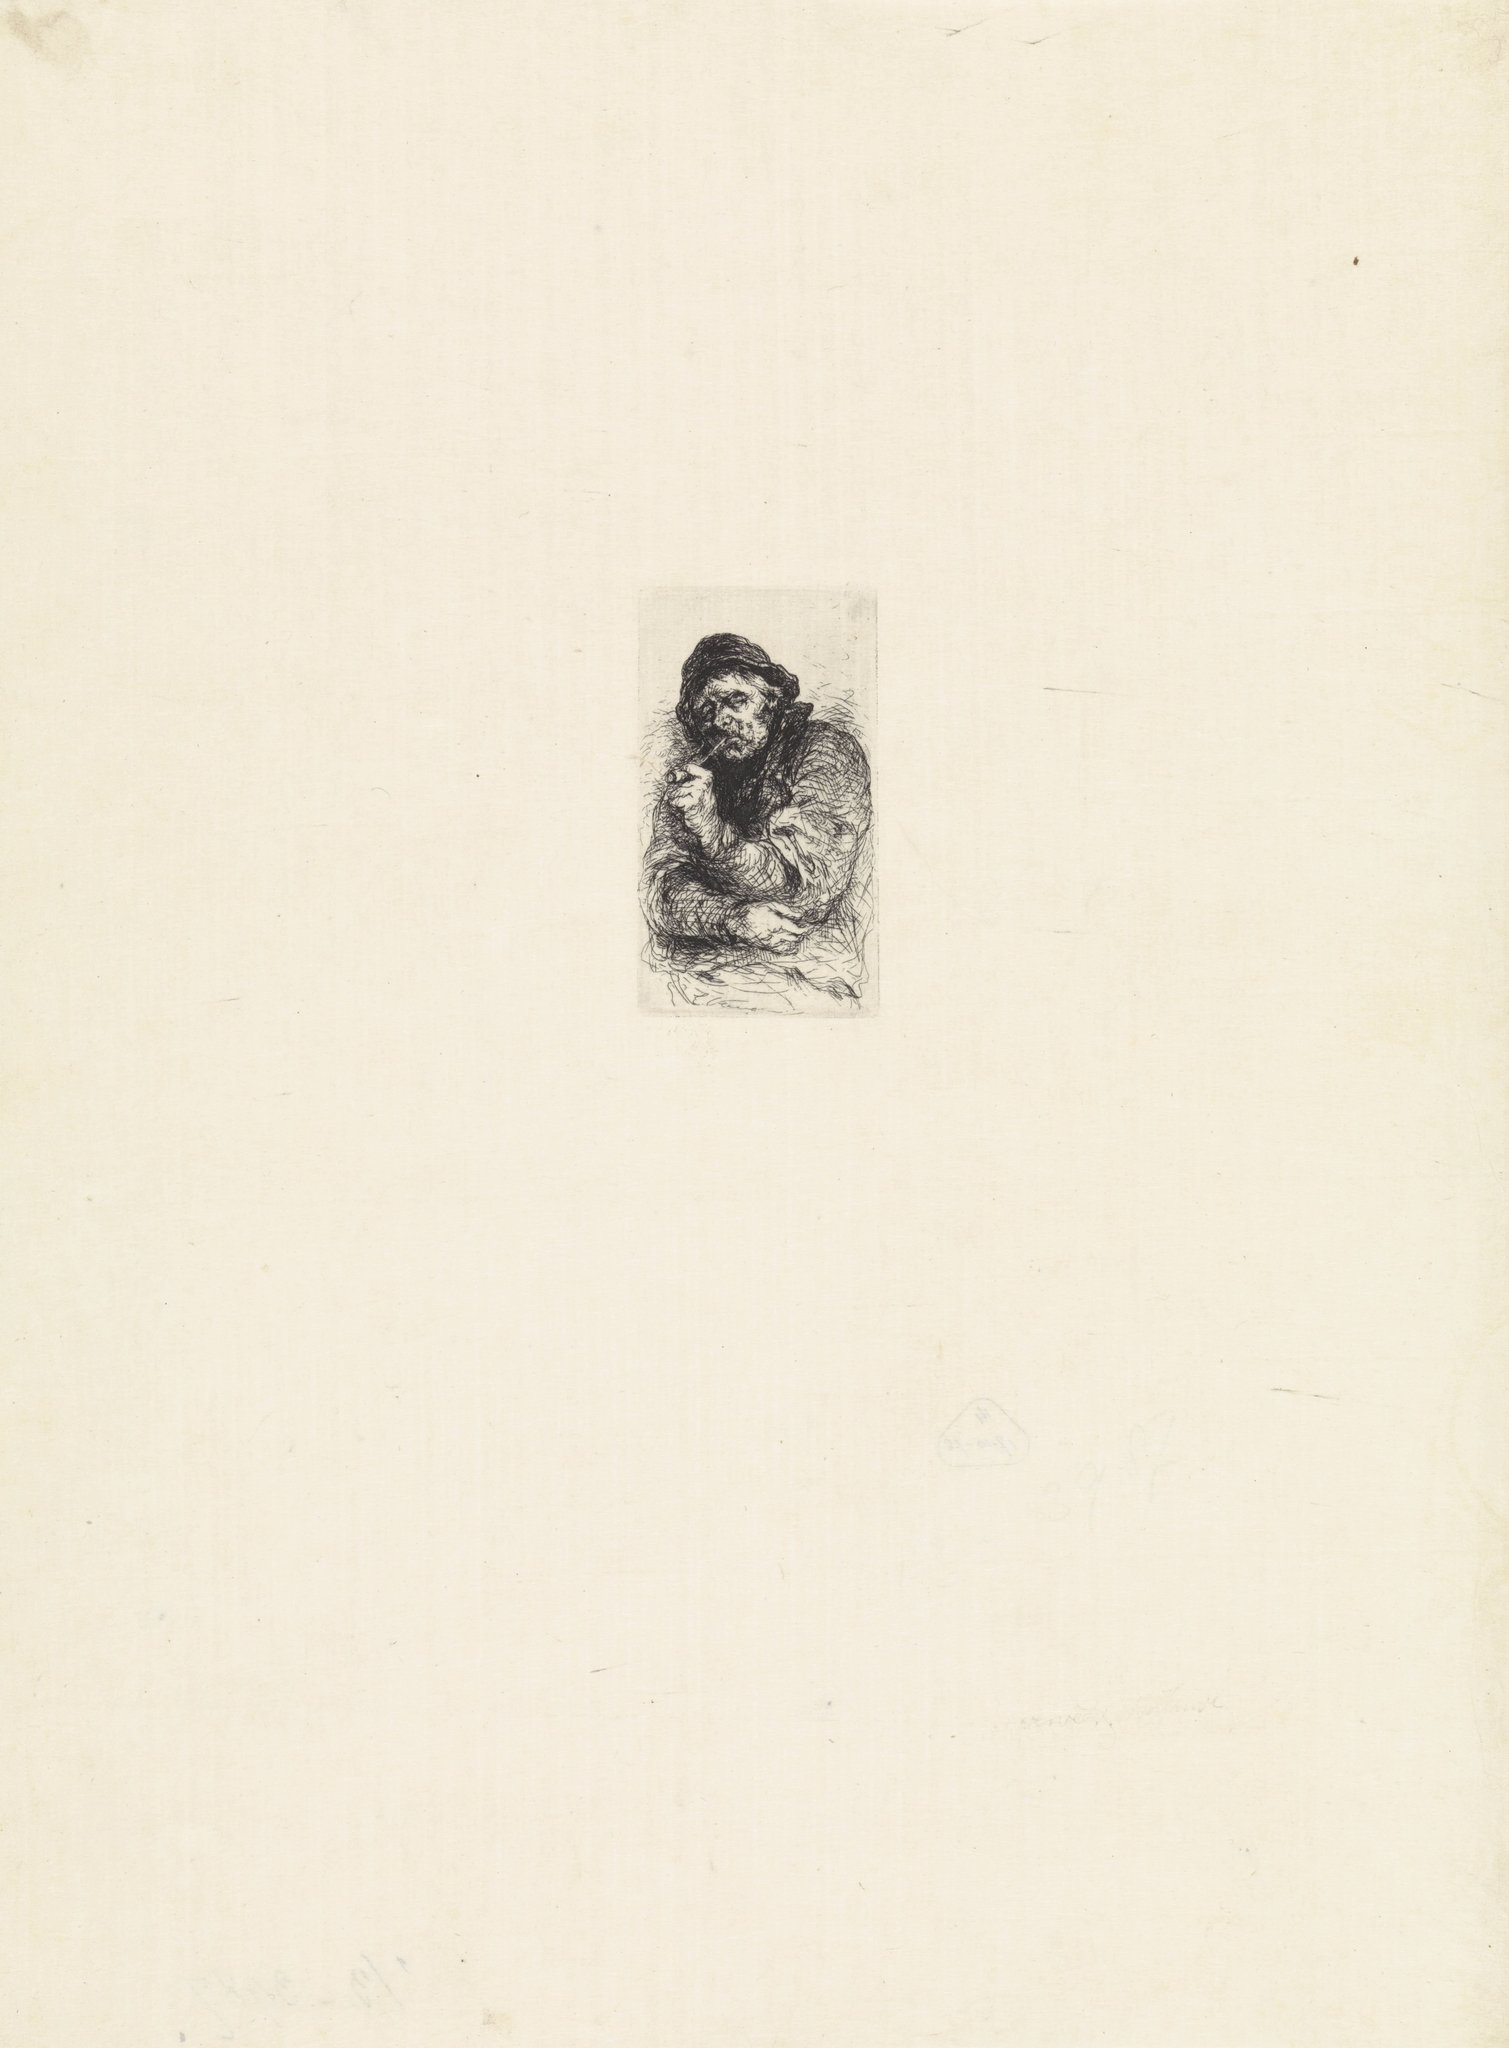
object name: print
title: Pijprokende visser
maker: elchanon verveer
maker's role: draughtsman, print maker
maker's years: 1826-1900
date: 1836-1900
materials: paper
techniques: etching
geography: the hague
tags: pipe ~ tobacco, fisherman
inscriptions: collector's mark: Lugt 2228